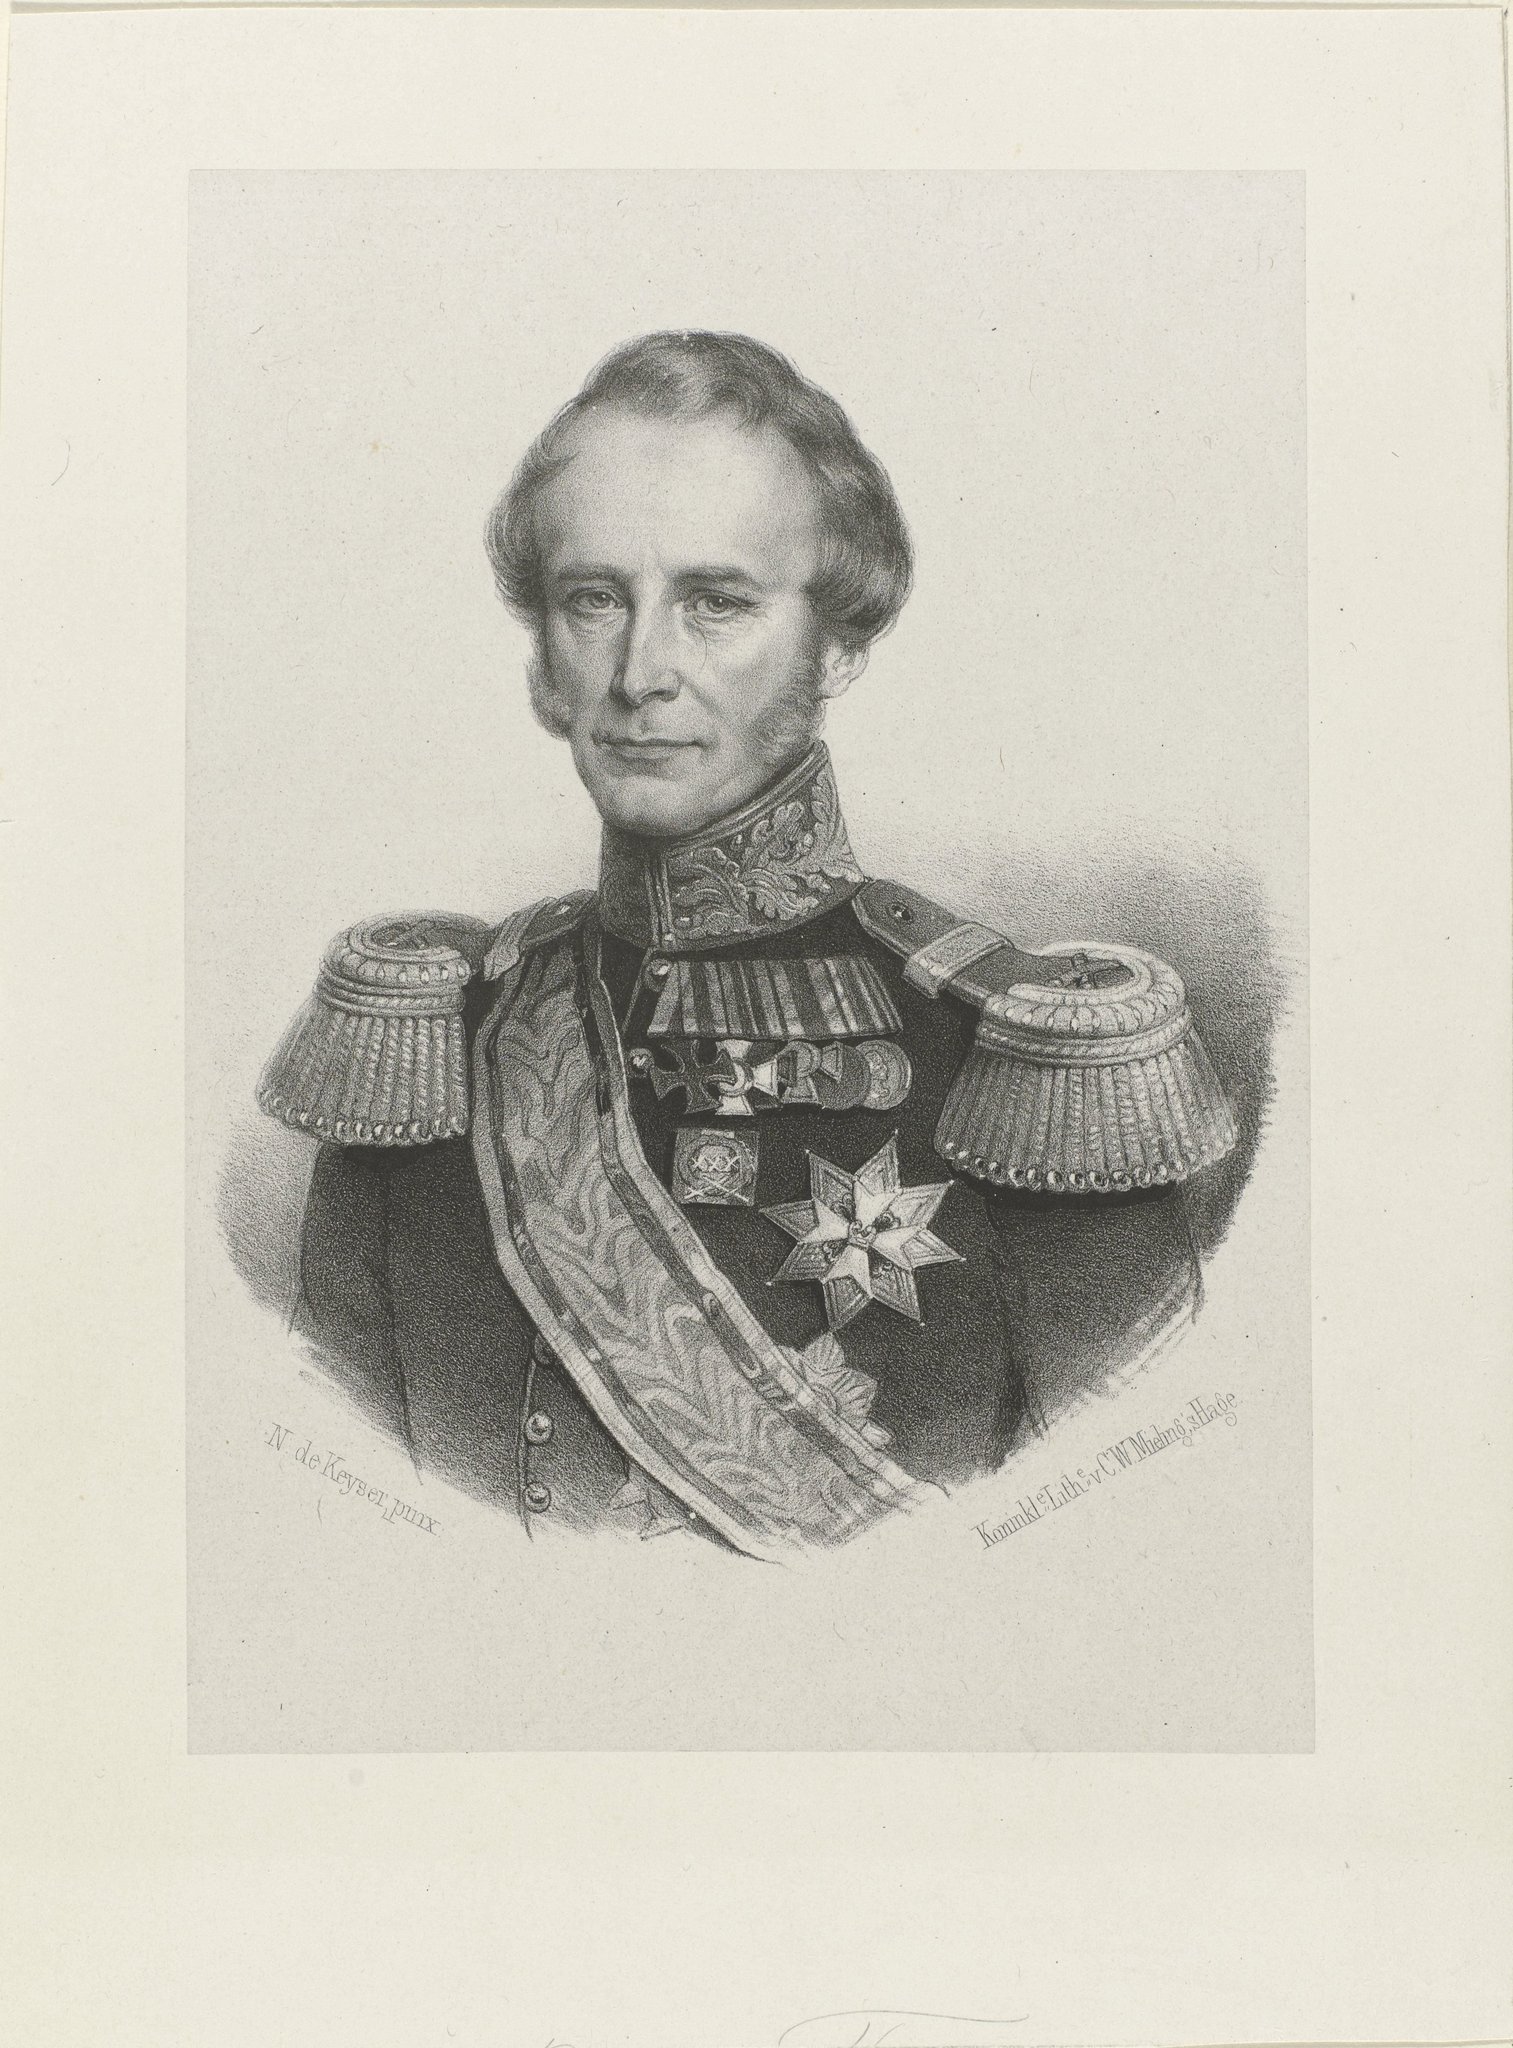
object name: print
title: Portret van Frederik, prins der Nederlanden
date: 1825-1871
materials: paper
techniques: lithograph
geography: the hague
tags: berlin, frederik (prins der nederlanden)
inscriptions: collector's mark: Lugt 963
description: De hier vermelde titel verwijst naar de hoogst verkregen titel van de geportretteerde, niet per se naar de titel die de geportretteerde op deze voorstelling draagt.